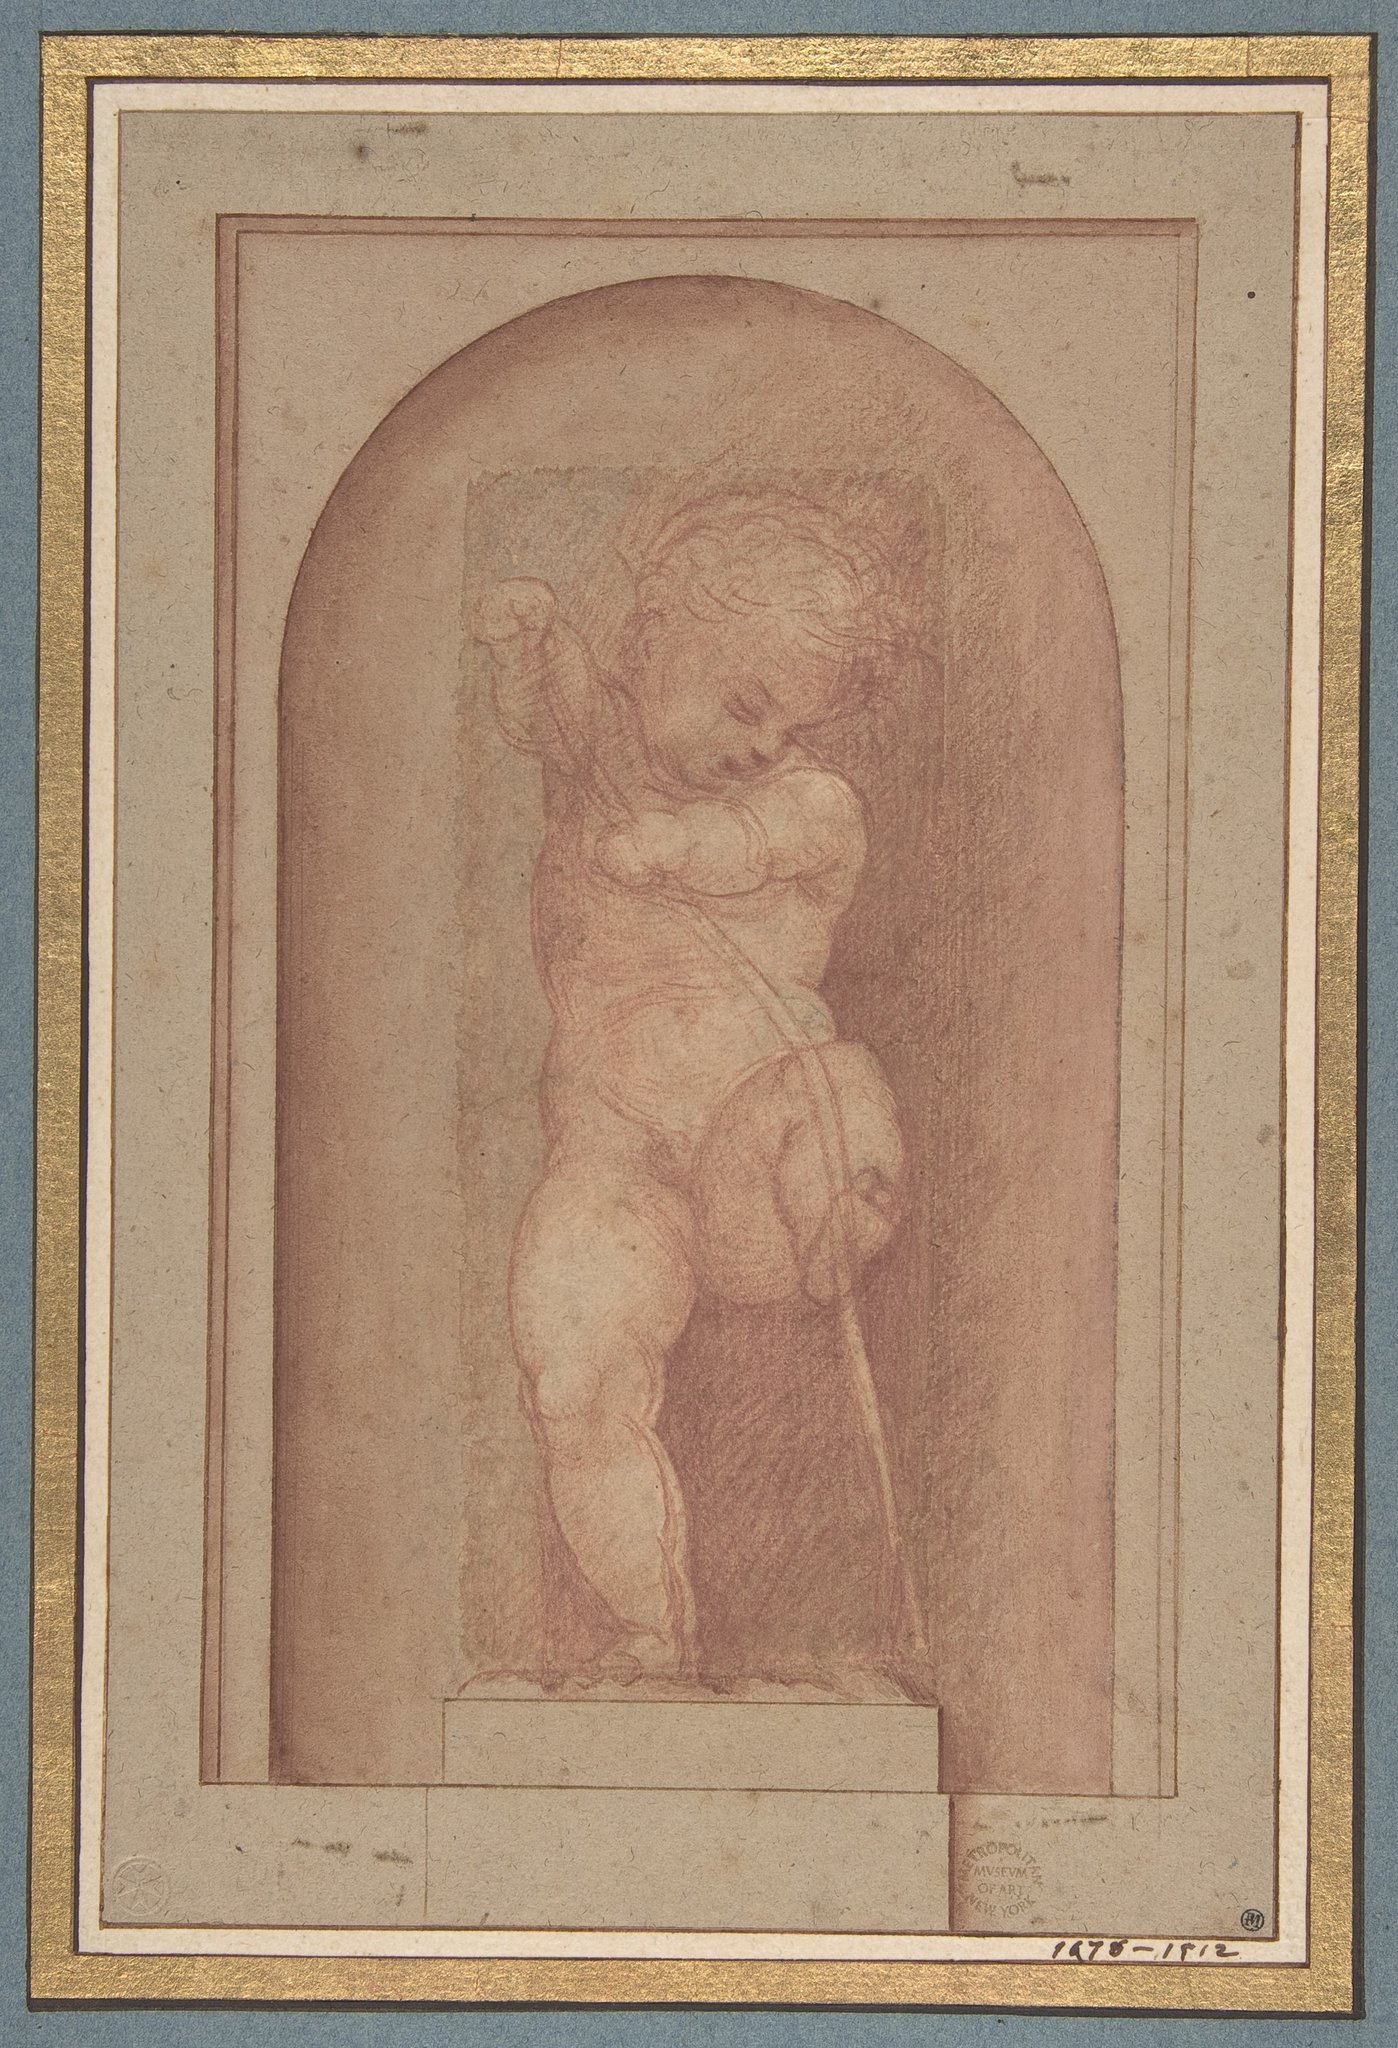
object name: drawing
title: Putto Bending a Bow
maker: giorgione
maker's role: artist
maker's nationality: italian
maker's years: 1477-1510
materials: chalk, ink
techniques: brush, pen, wash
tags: cupid